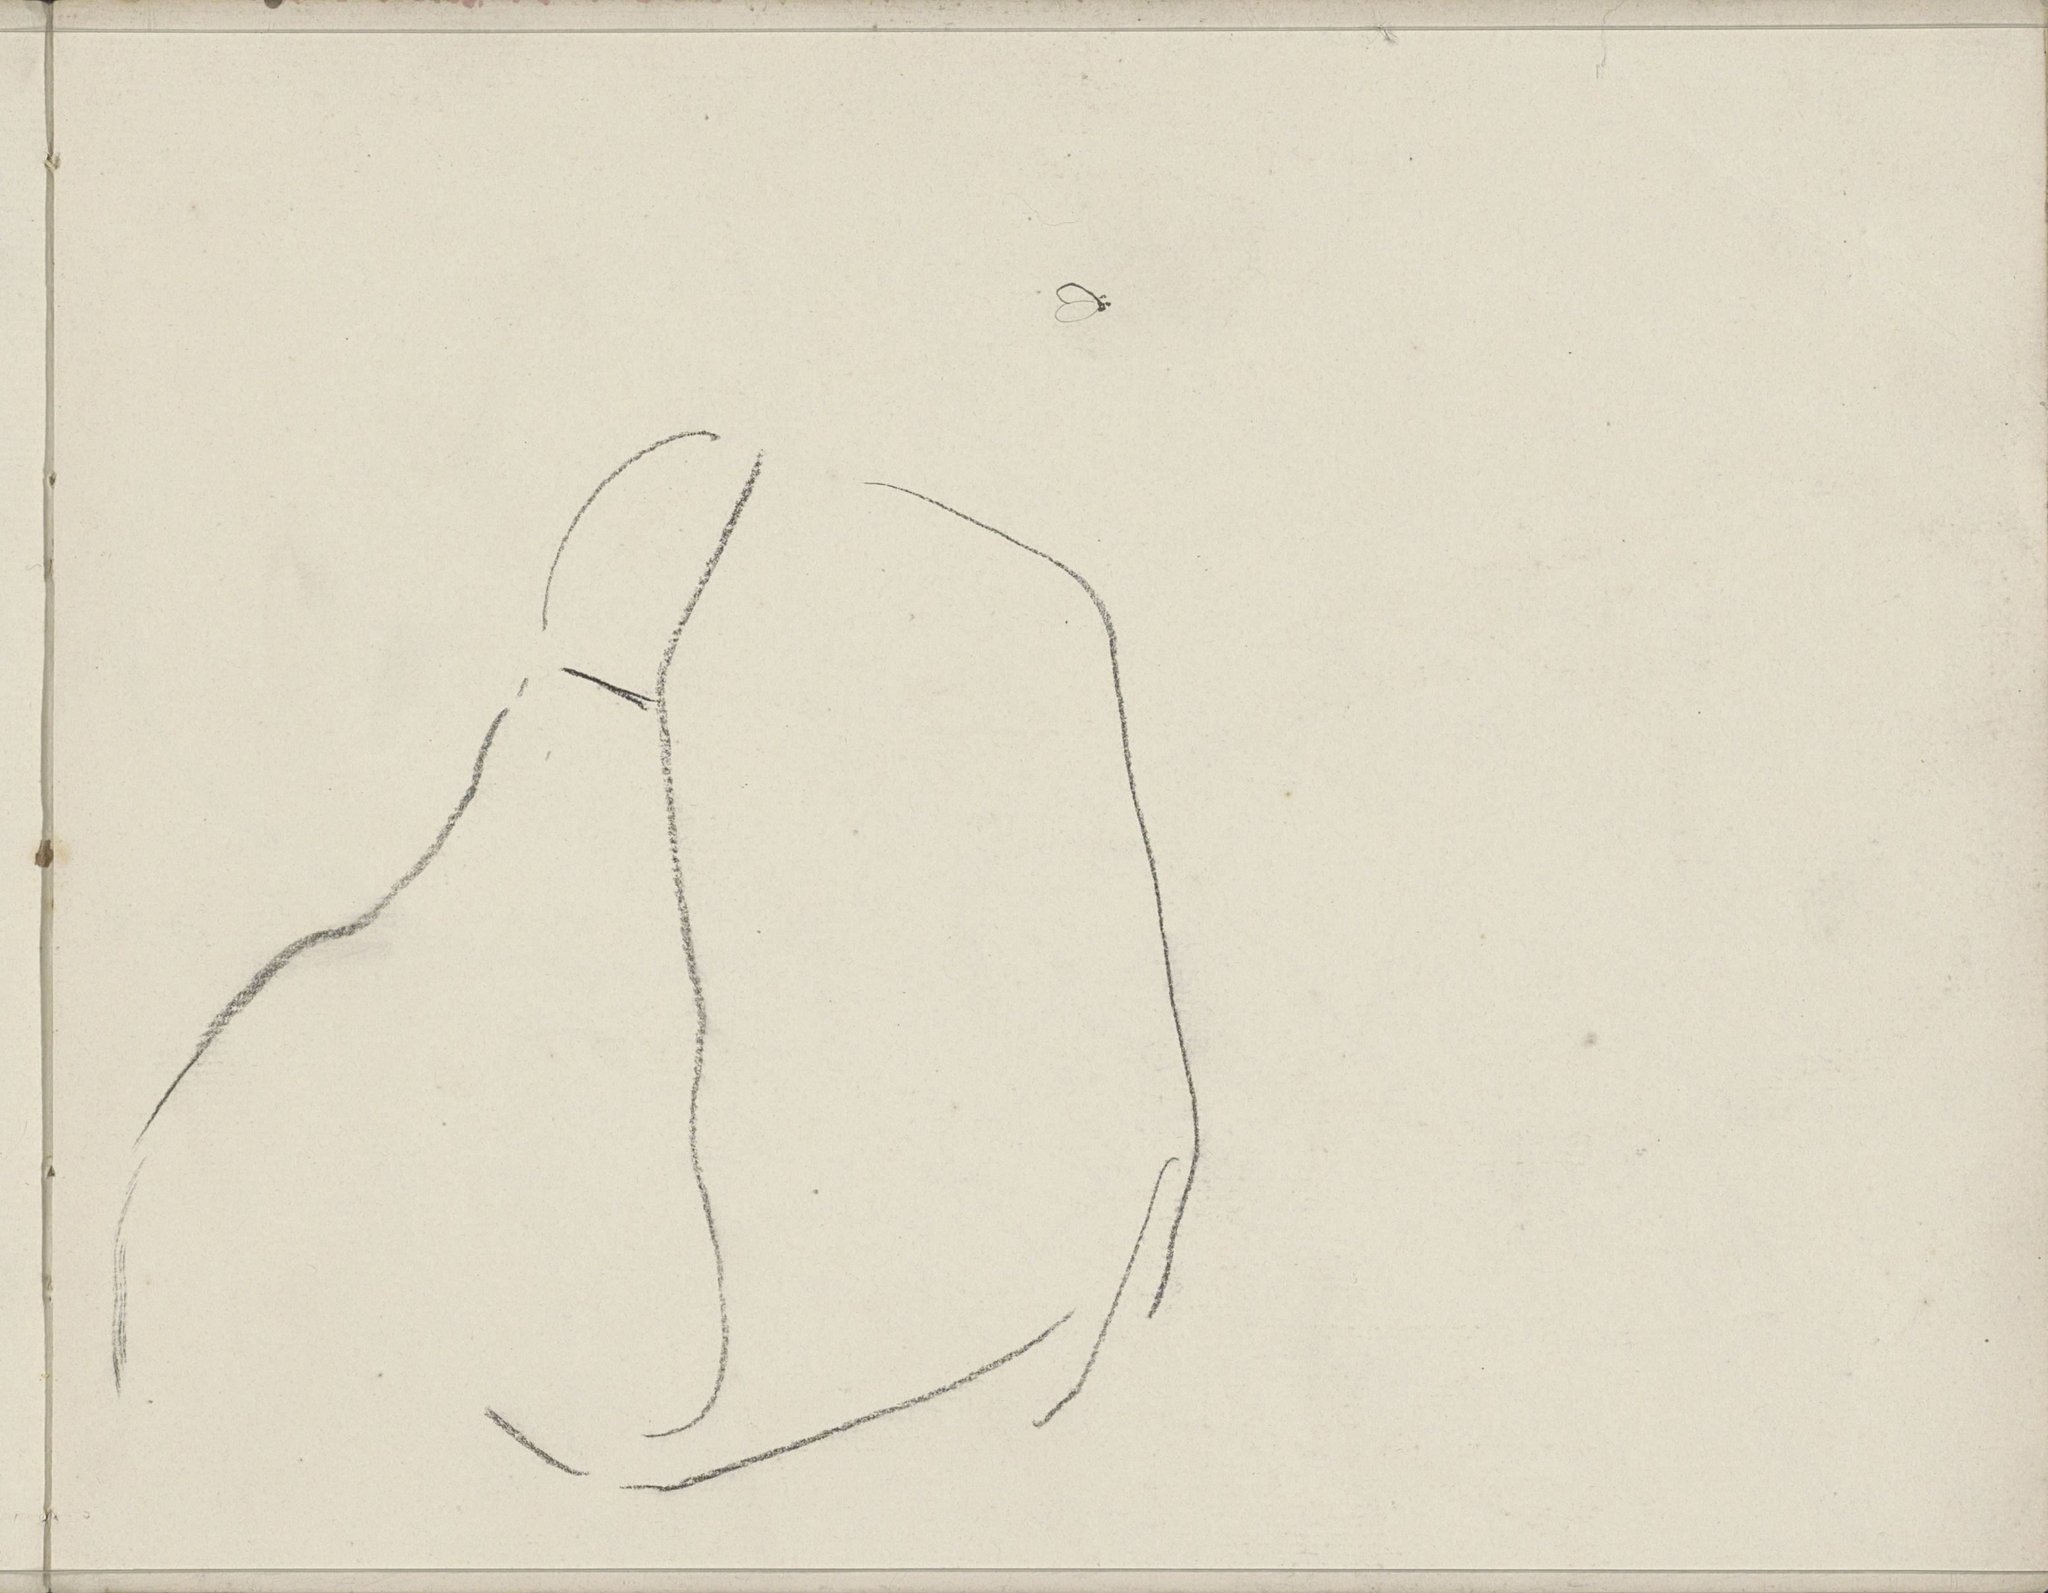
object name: sketchbook leaf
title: Studie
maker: carel adolph lion cachet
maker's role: draughtsman, print maker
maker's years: 1864-1945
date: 1896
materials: chalk, paper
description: Blad 39 recto uit een schetsboek met 44 bladen.